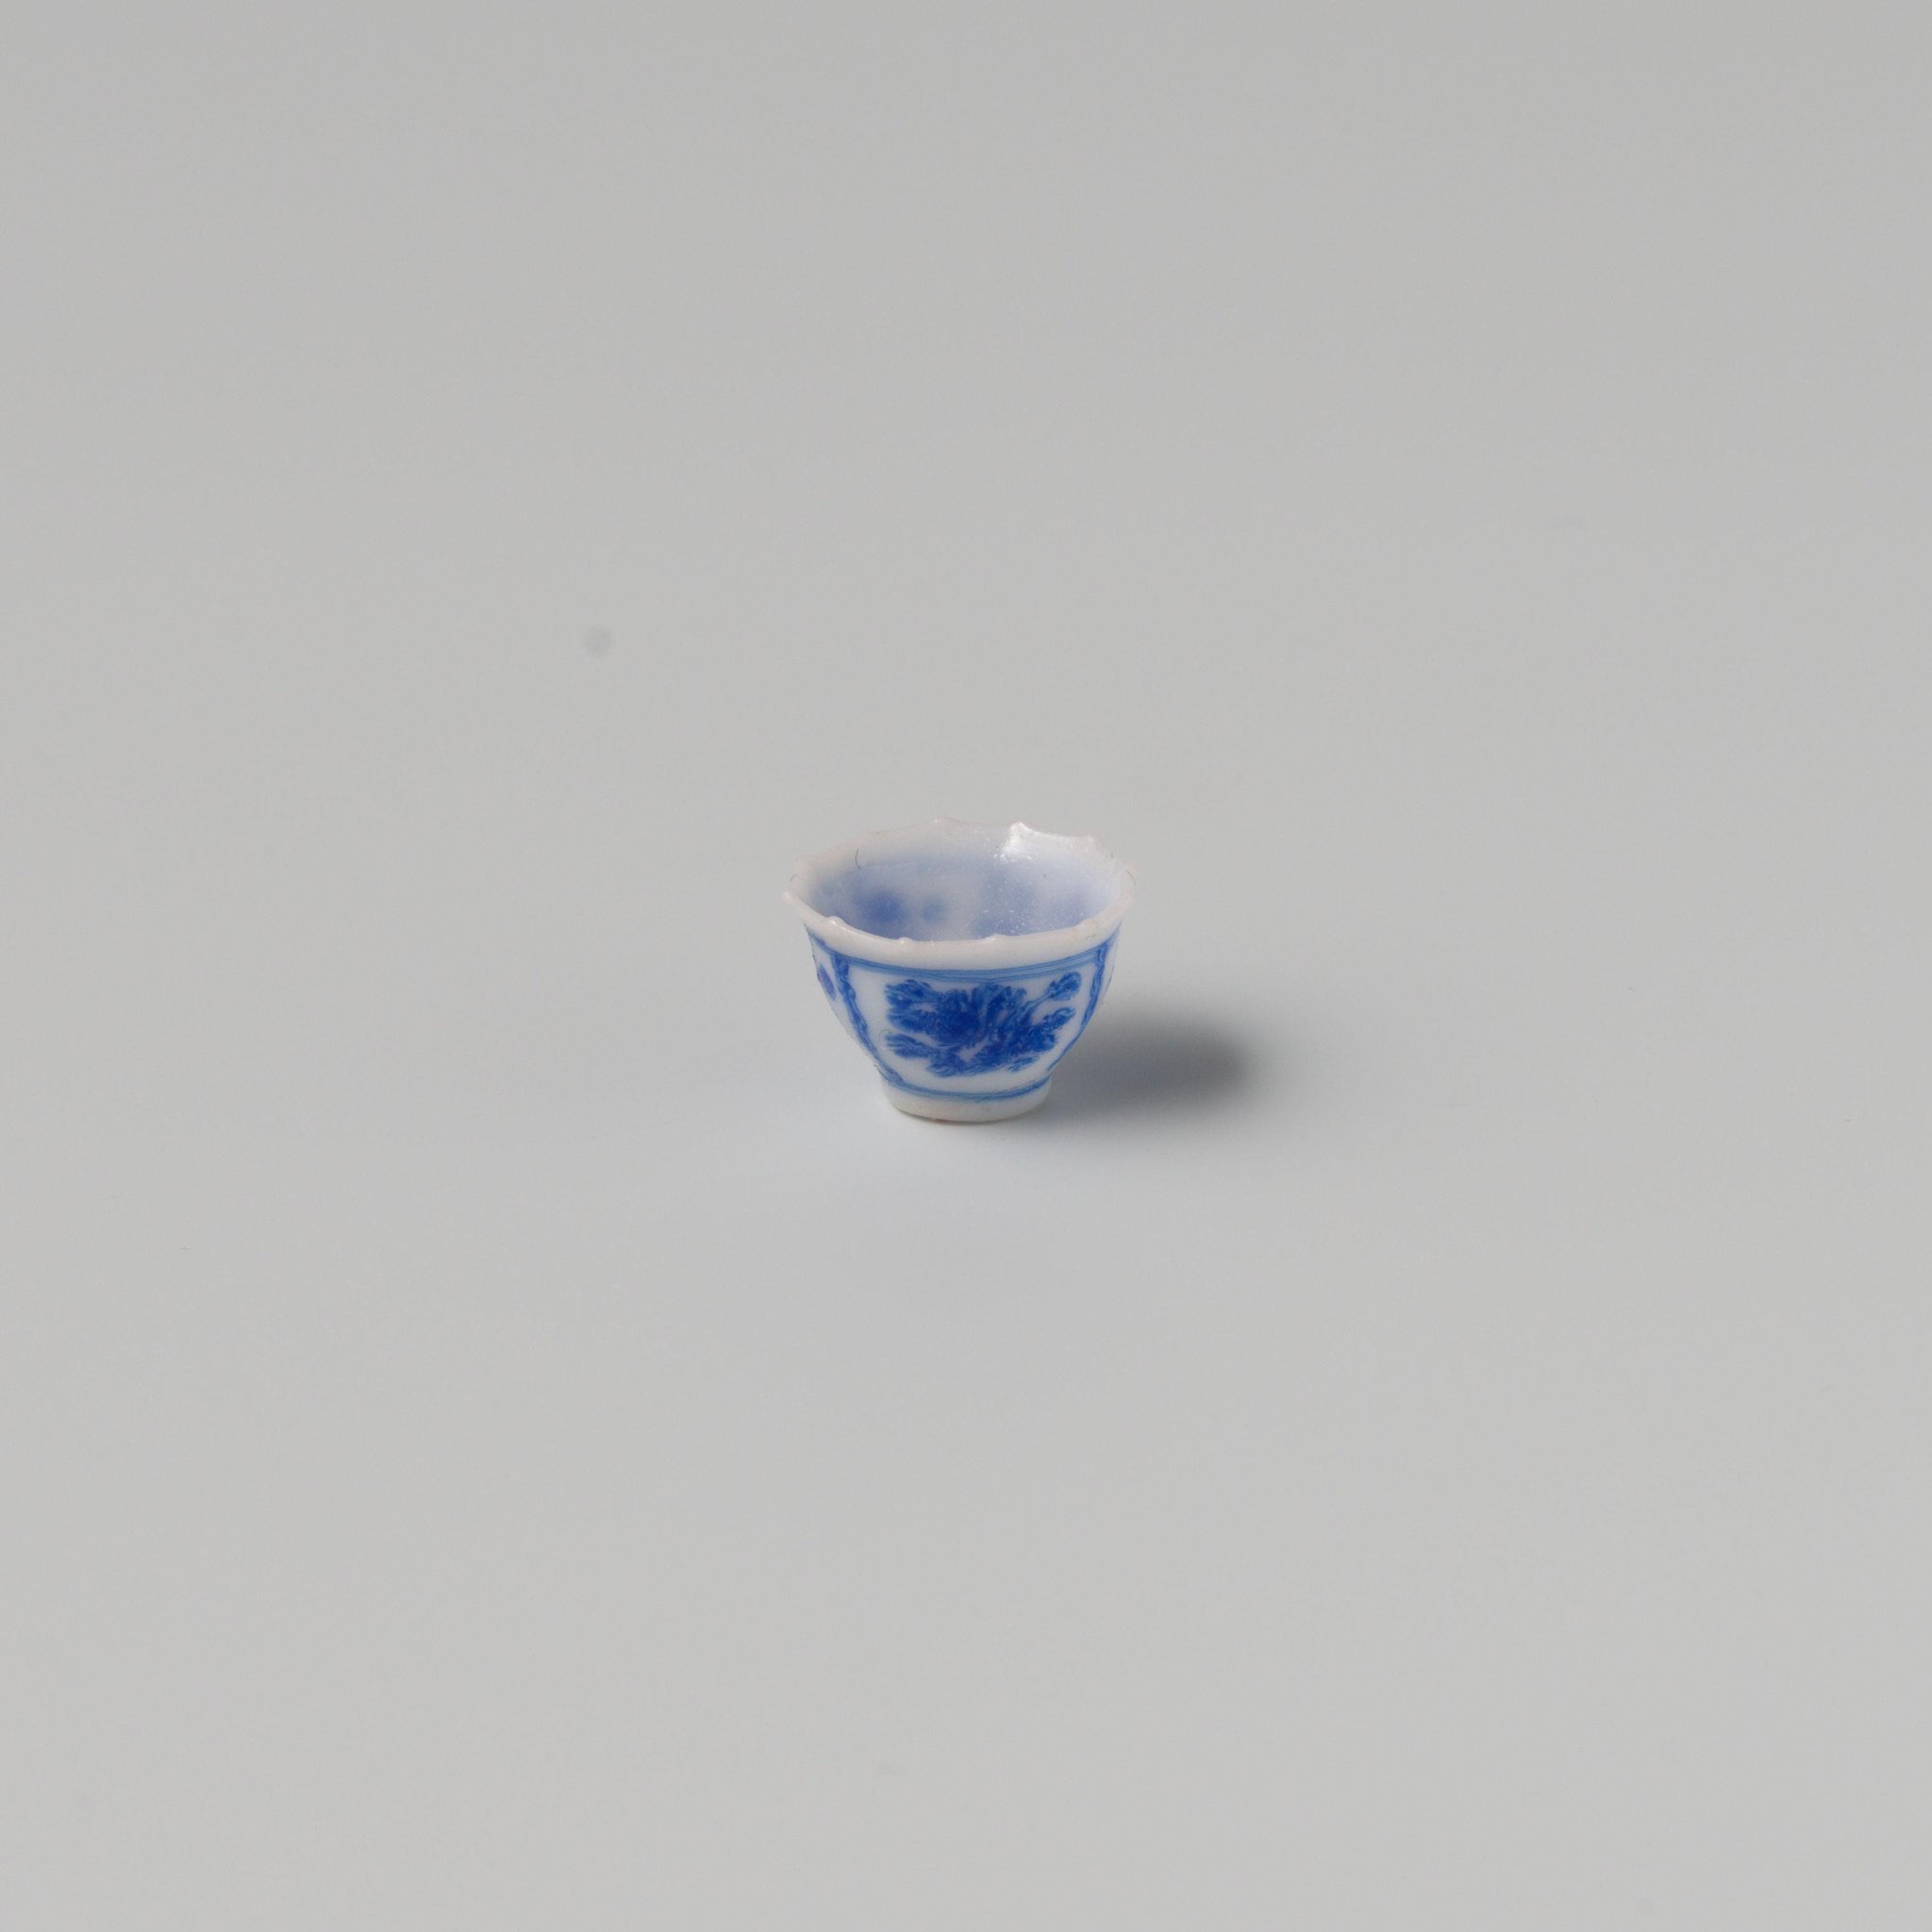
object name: miniature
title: Theekopje van melkglas met blauwe emailverf beschildering, imitatie Chinees porselein met 'bloem' decoratie in drie vakken; model met puntrand, nauwelijks een standring.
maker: Anonymous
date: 1675-1710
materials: glass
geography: amsterdam